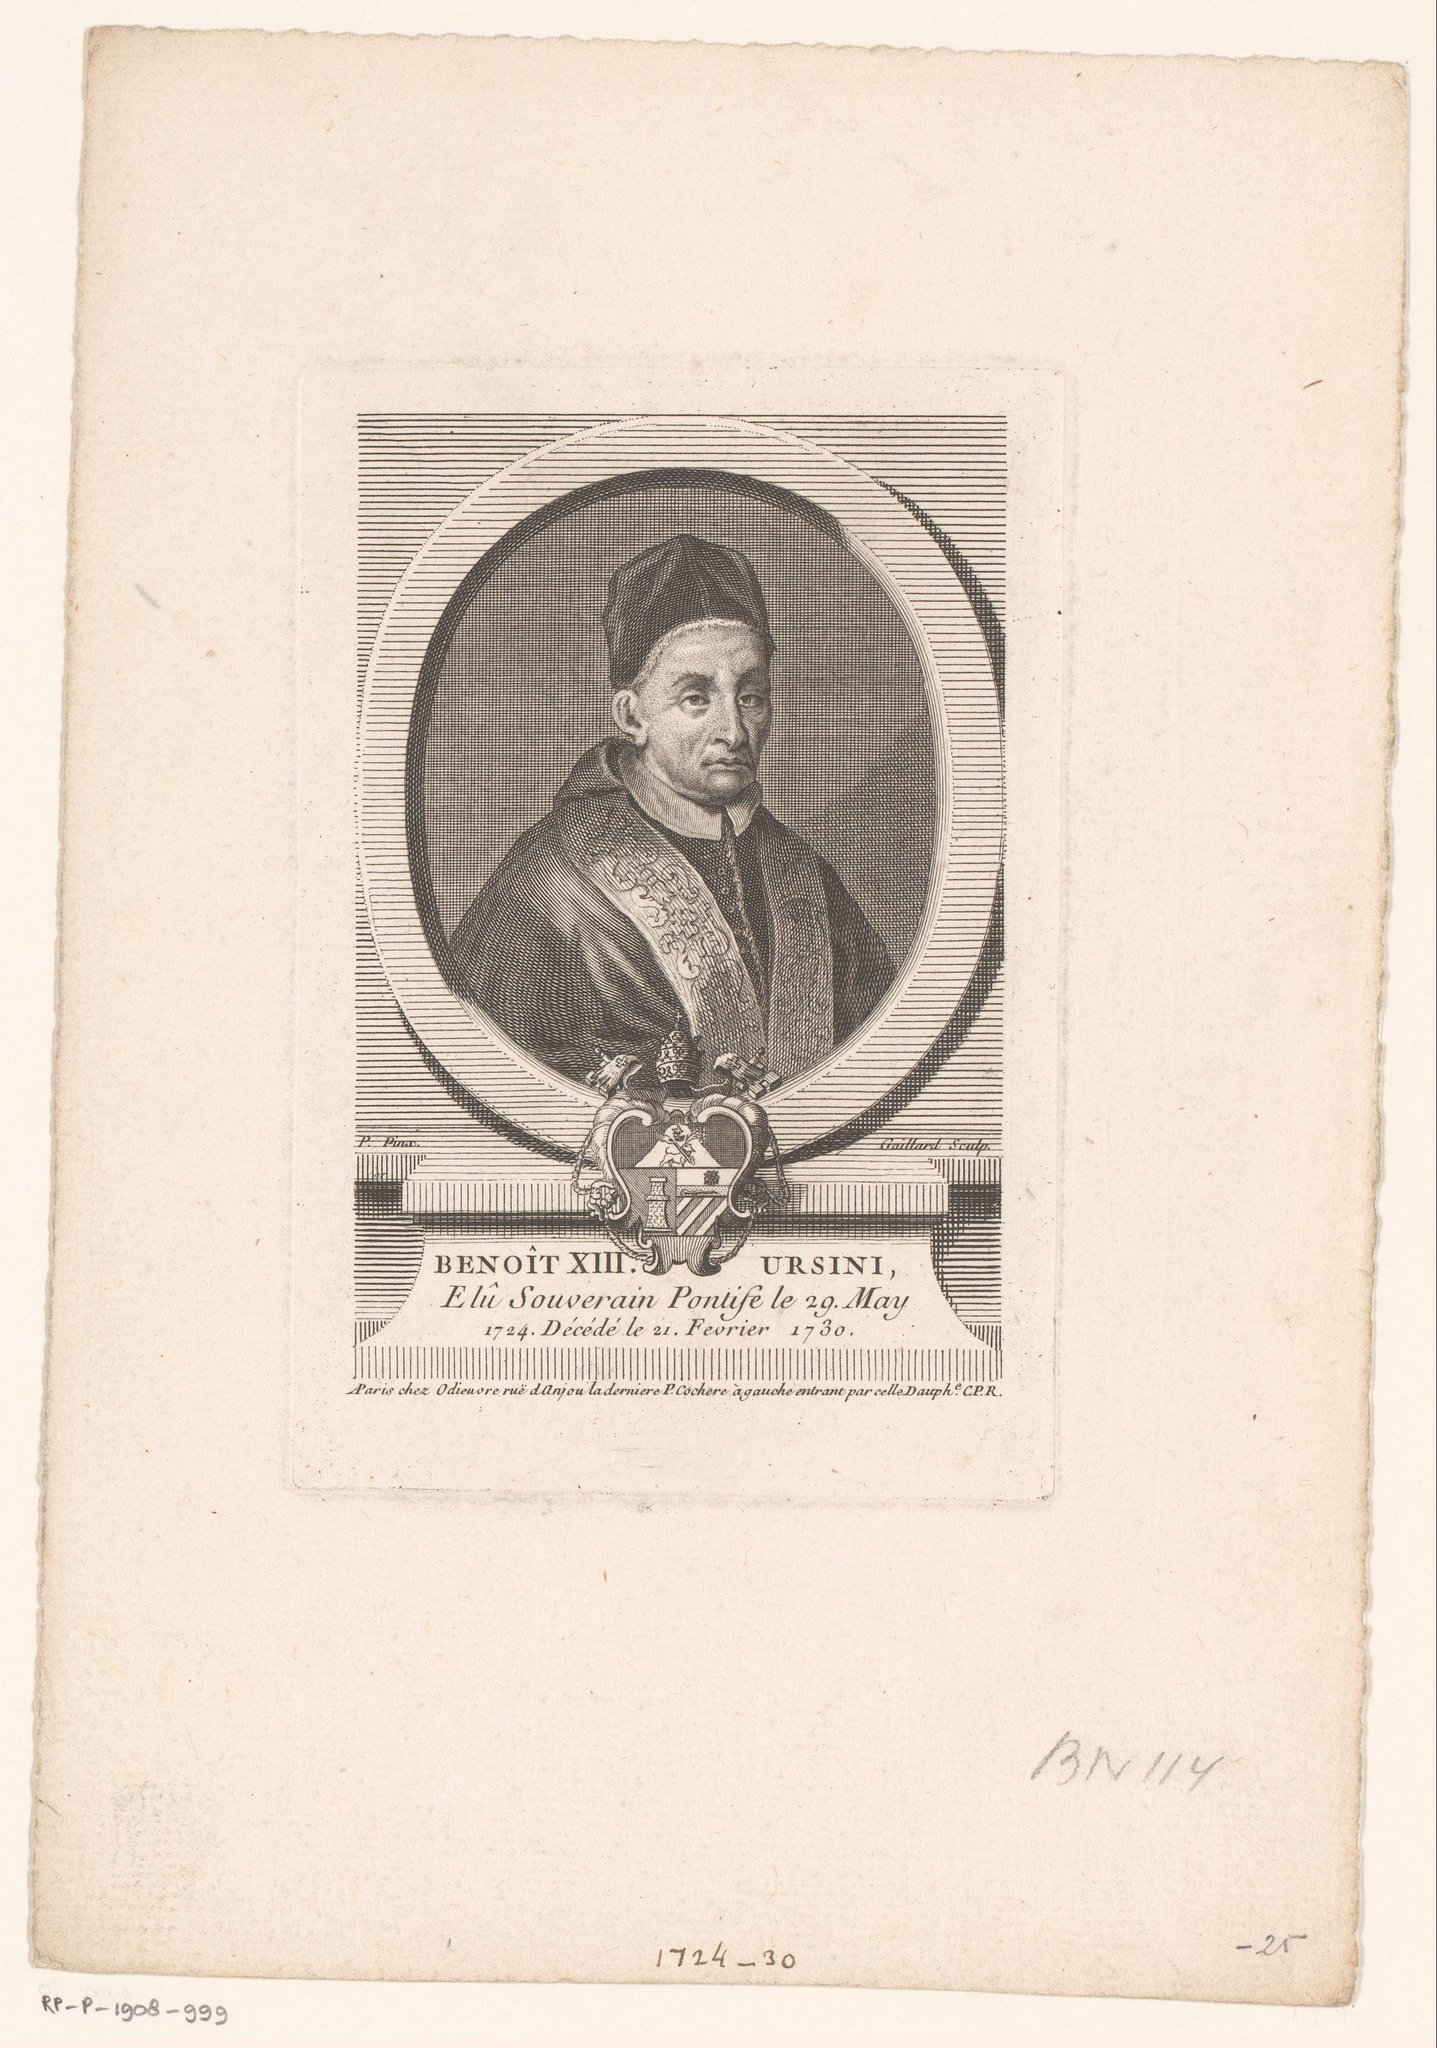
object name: print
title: Portret van Benedictus XIII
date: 1755-1765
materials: paper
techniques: engraving, etching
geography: paris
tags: benedictus xiii, historical persons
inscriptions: collector's mark: Lugt 2228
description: Mogelijk prent uit: Dreux du Radier, Jean-François. L'Europe illustré, contenant l'histoire abregée des souverains, des princes, des prélats, des ministres, (...) en Europe: dans le XVe. siècle compris, jusqu'à présent. Parijs: Michel Odieuvre en André-François Le Breton, 1755-1765, dl. 4.